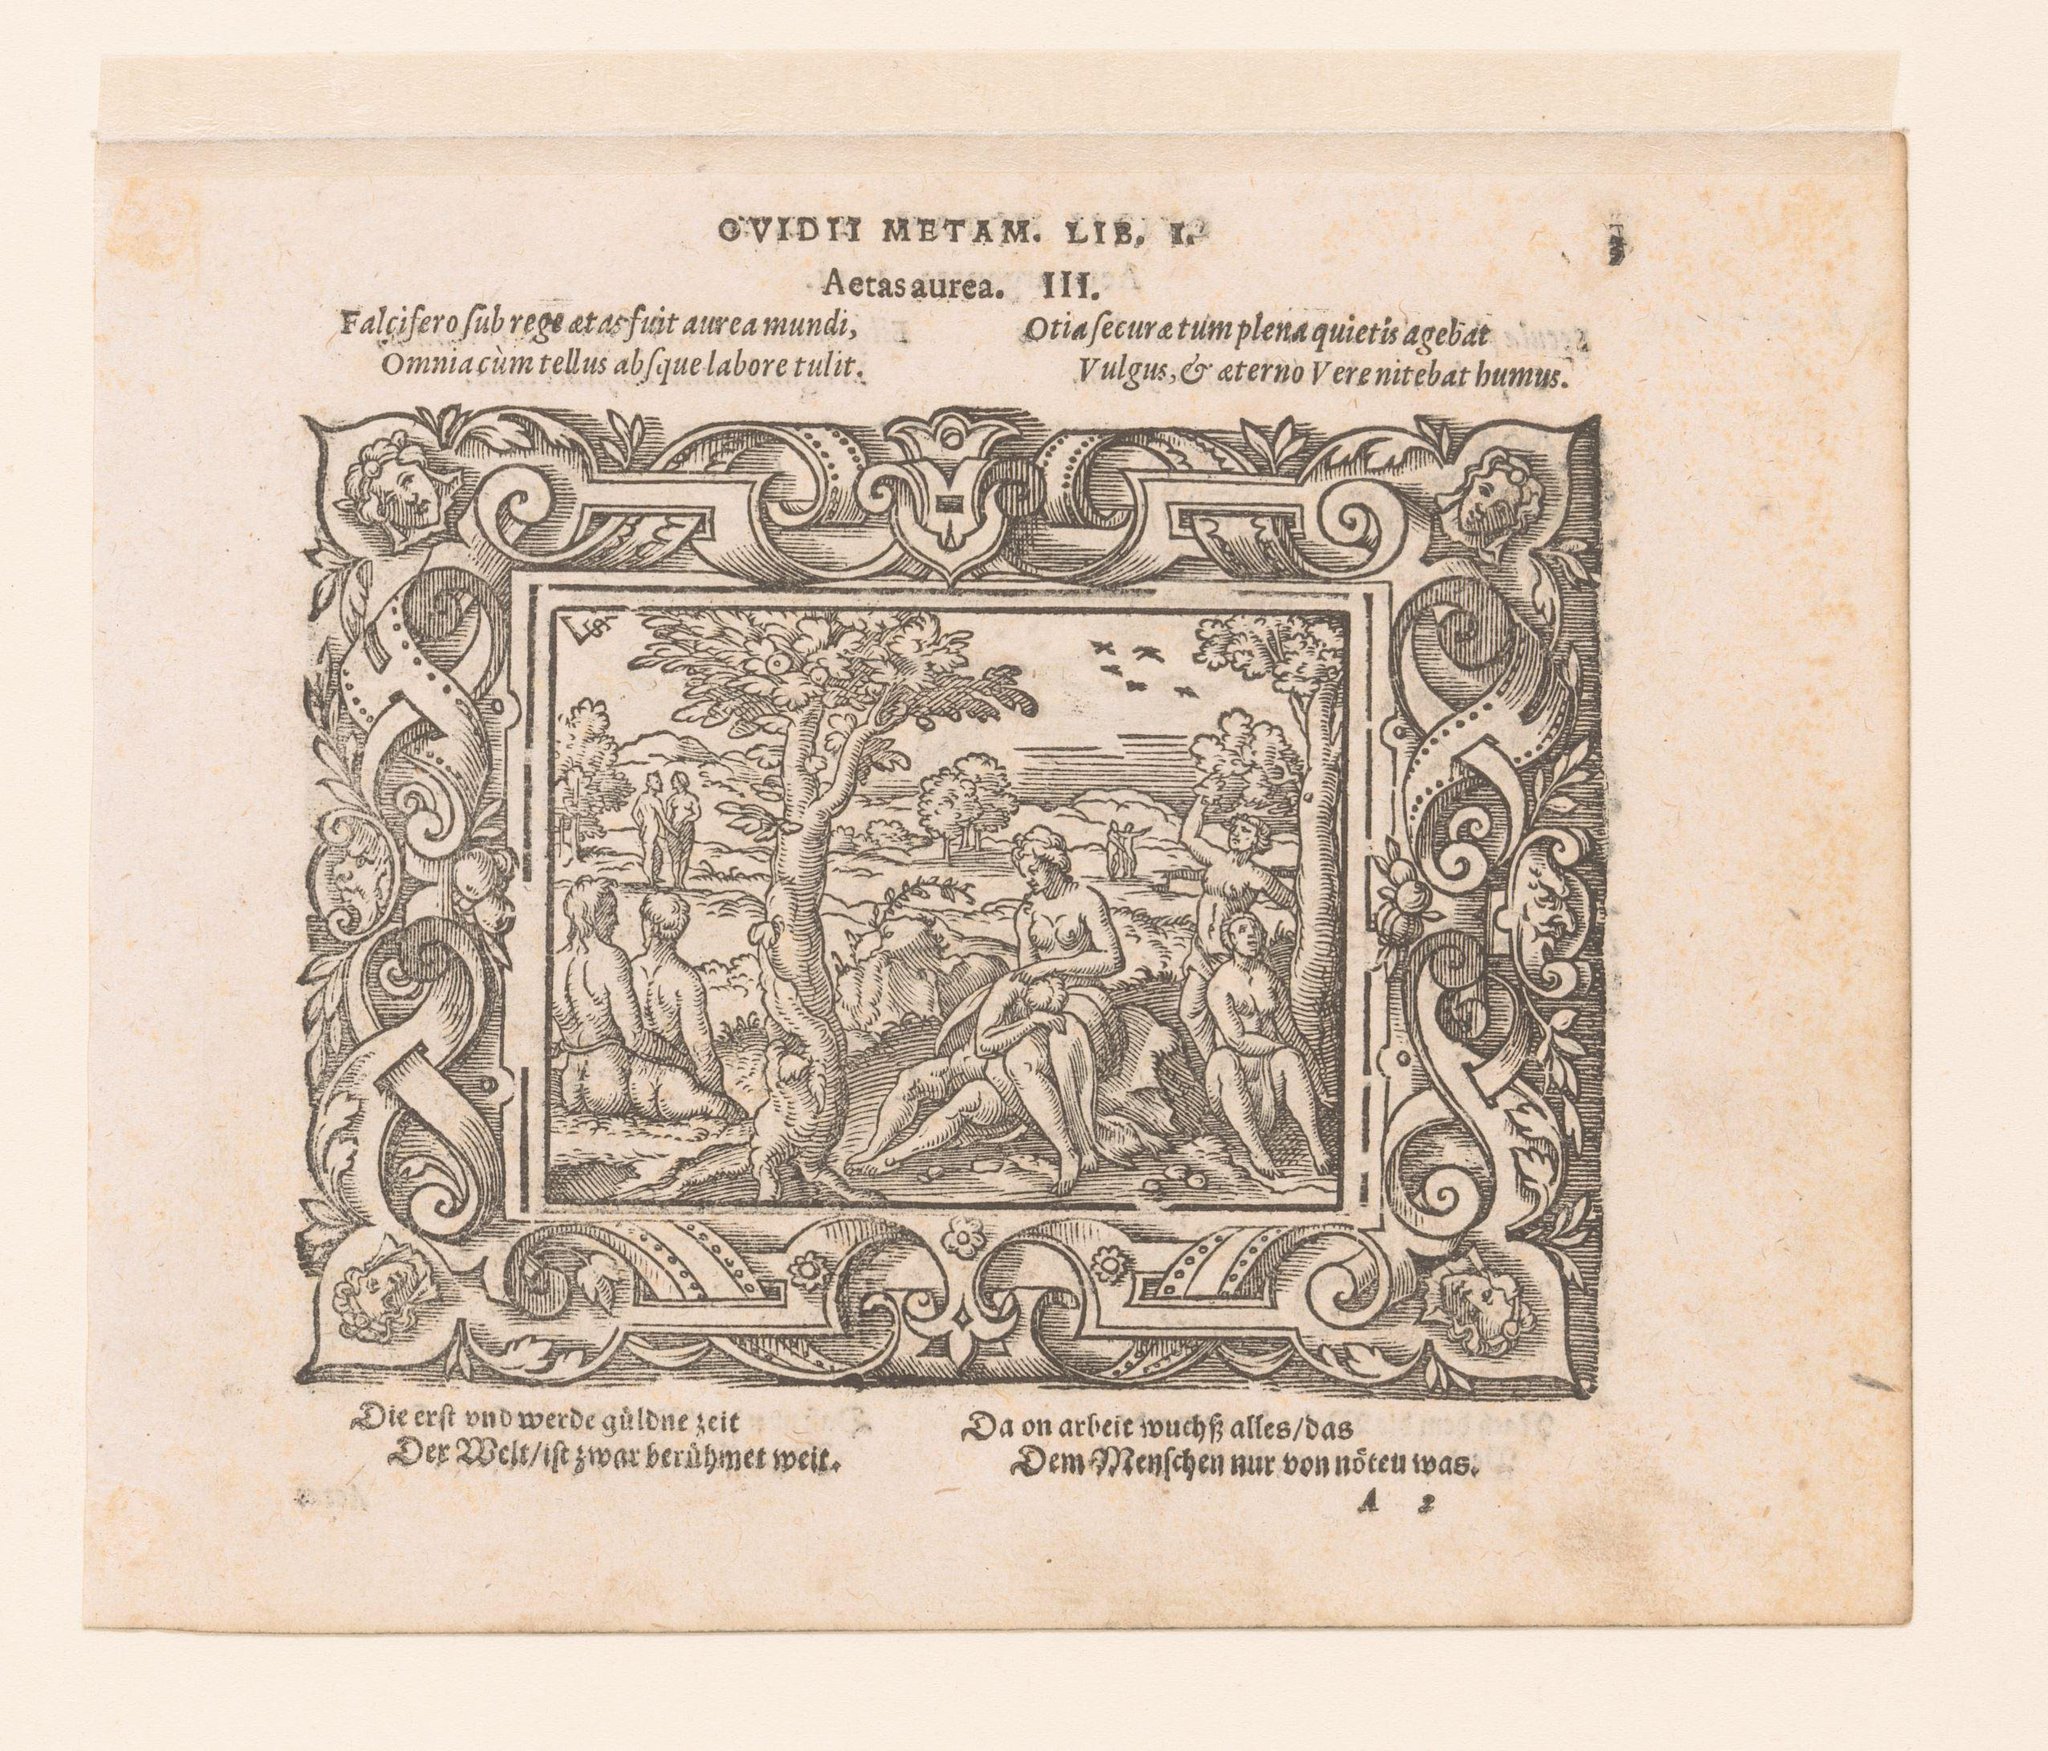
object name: print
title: Gouden Eeuw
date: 1569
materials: paper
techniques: letterpress printing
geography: nuremberg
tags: scrollwork, strapwork ~ ornament, the golden age, 'aetas aurea'; men live happily, gathering fruits under the reign of saturn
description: Illustratie bij de Metamorfosen van Ovidius, afkomstig uit de publicatie: Posthius, Johannes. Tetrasticha in Ovidii metam. Frankfurt am Main: Georg Rab en Sigmund Feyerabend en erven Weigand Han, 1569. De voorstellingen en ornamentranden van deze boekillustraties zijn van twee aparte blokken gedrukt. Beide werden afzonderlijk van elkaar ook gebruikt voor andere publicaties, en de ornamentranden werden eveneens binnen deze publicatie meerdere keren gebruikt.